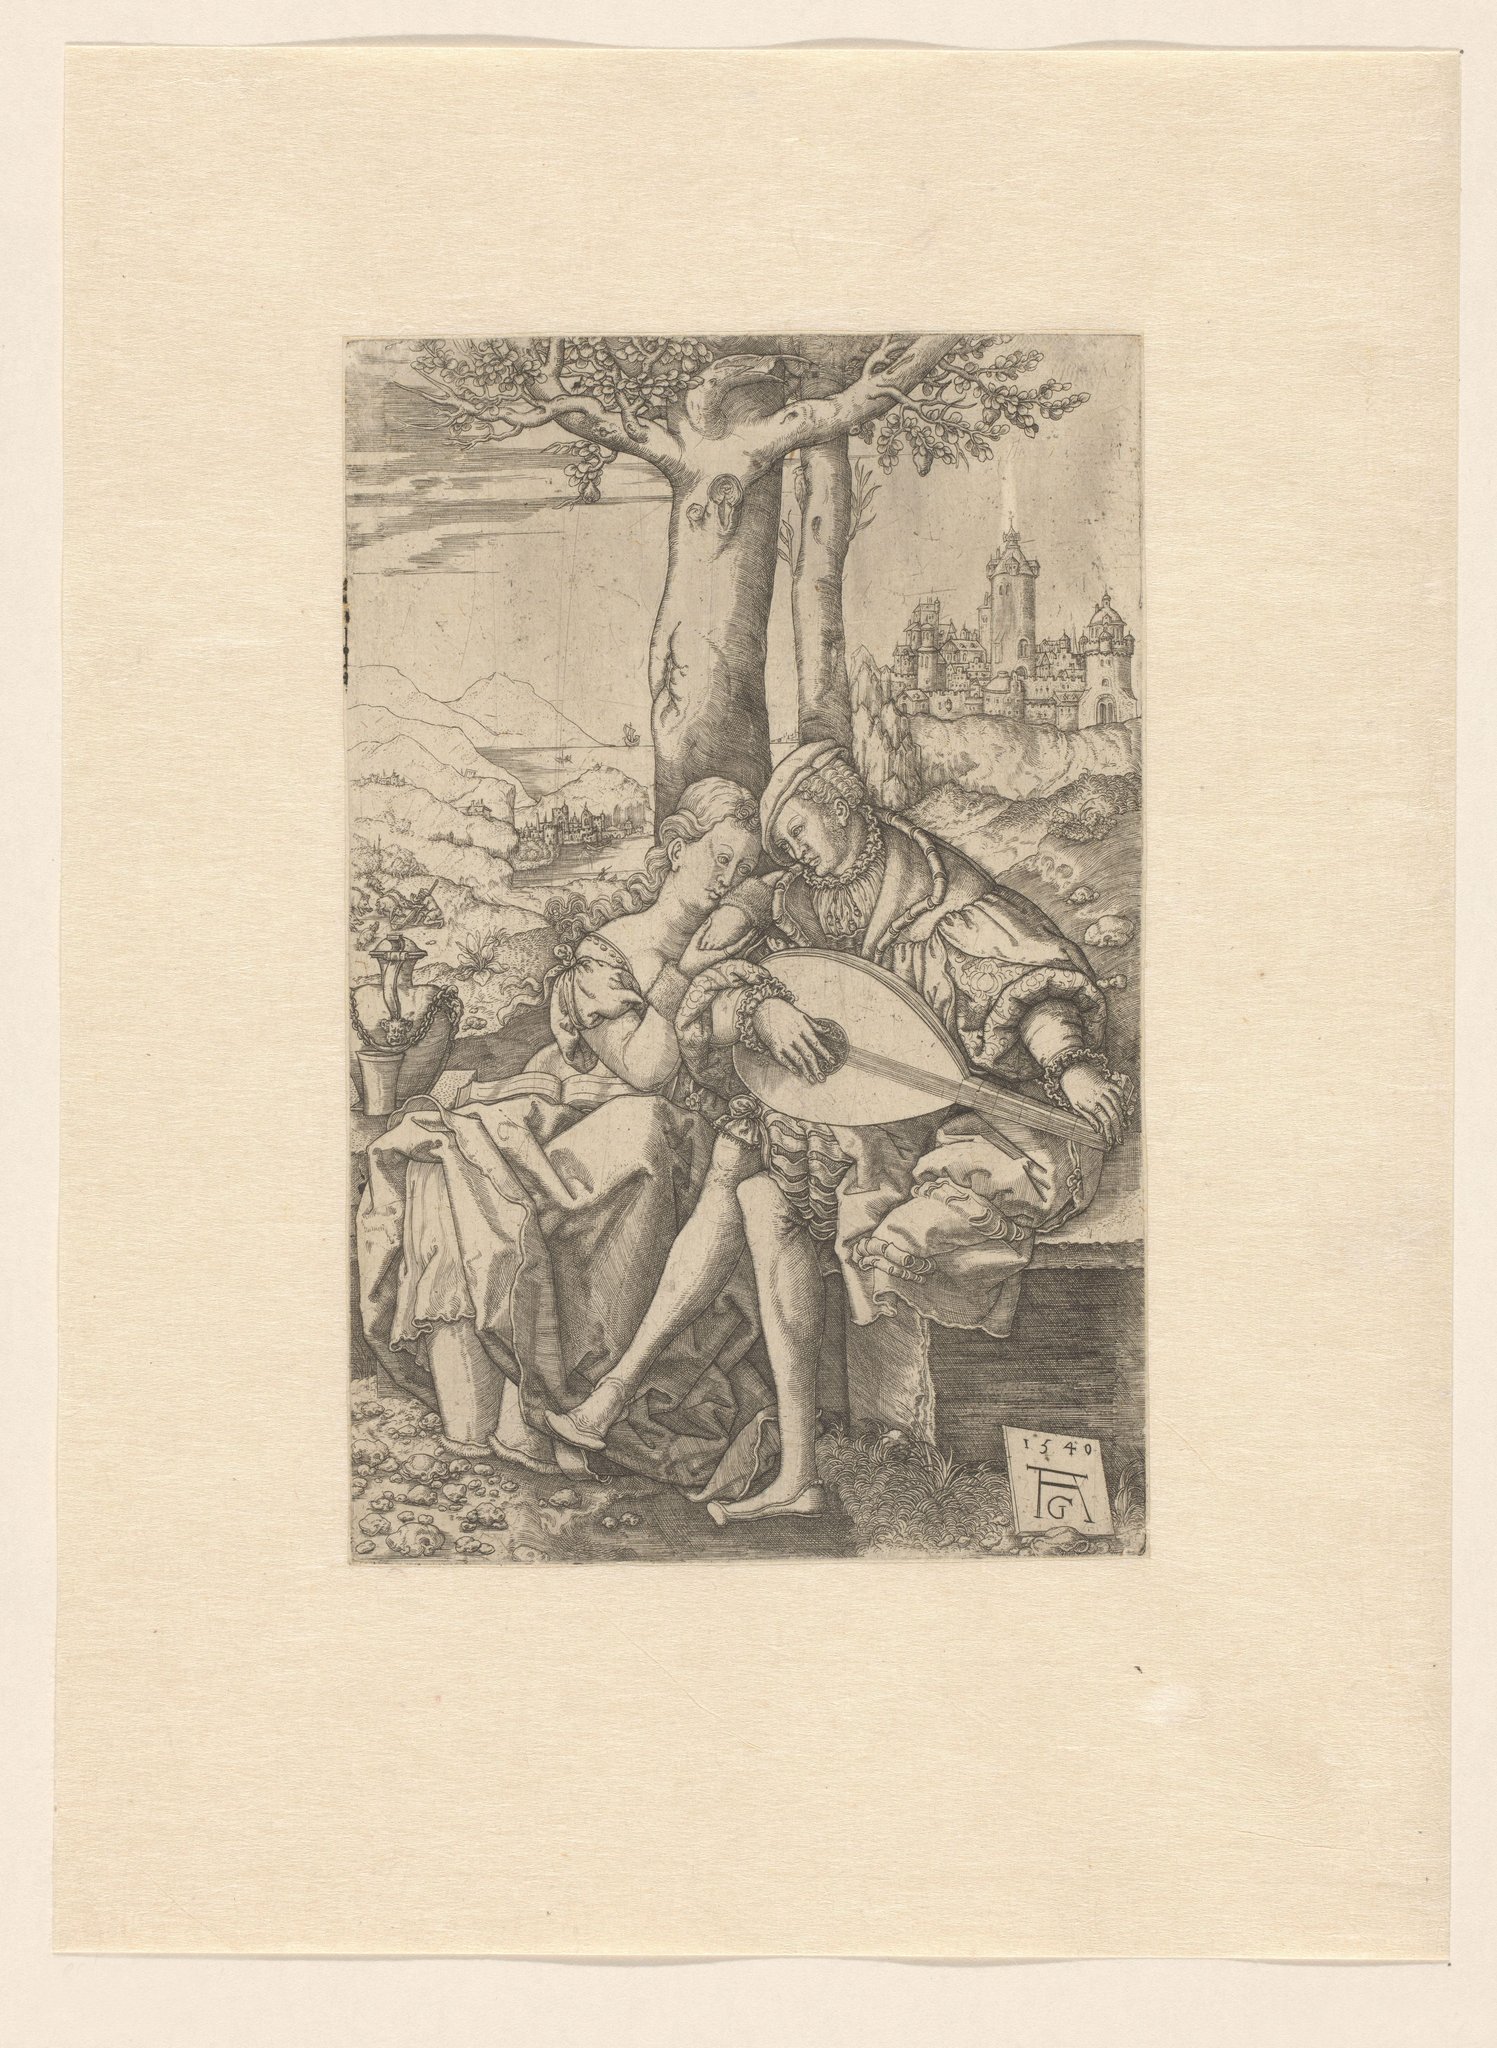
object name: print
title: Twee verliefden onder een boom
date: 1540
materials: paper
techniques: engraving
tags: lute, and special forms of lute, e.g.: theorbo, couple of lovers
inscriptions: collector's mark: Lugt 2228a, collector's mark: Lugt 2228, inscription: ‘AG’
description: Ihle p. 11, nr. 18: Musicerend paar. Kleding man: bonnet op het hoofd; paltrock met zeer lange mouwen. Hemd aan hals en polsen afgewerkt met een ruche (gerimpeld ?) Broek bestaat uit repen stof, gesloten met een lint, dat tevens de kousen ophouedt. Koemuilen. Vrouw met hangend haar. Japon met zeer lage hals. (publieke vrouw ?)